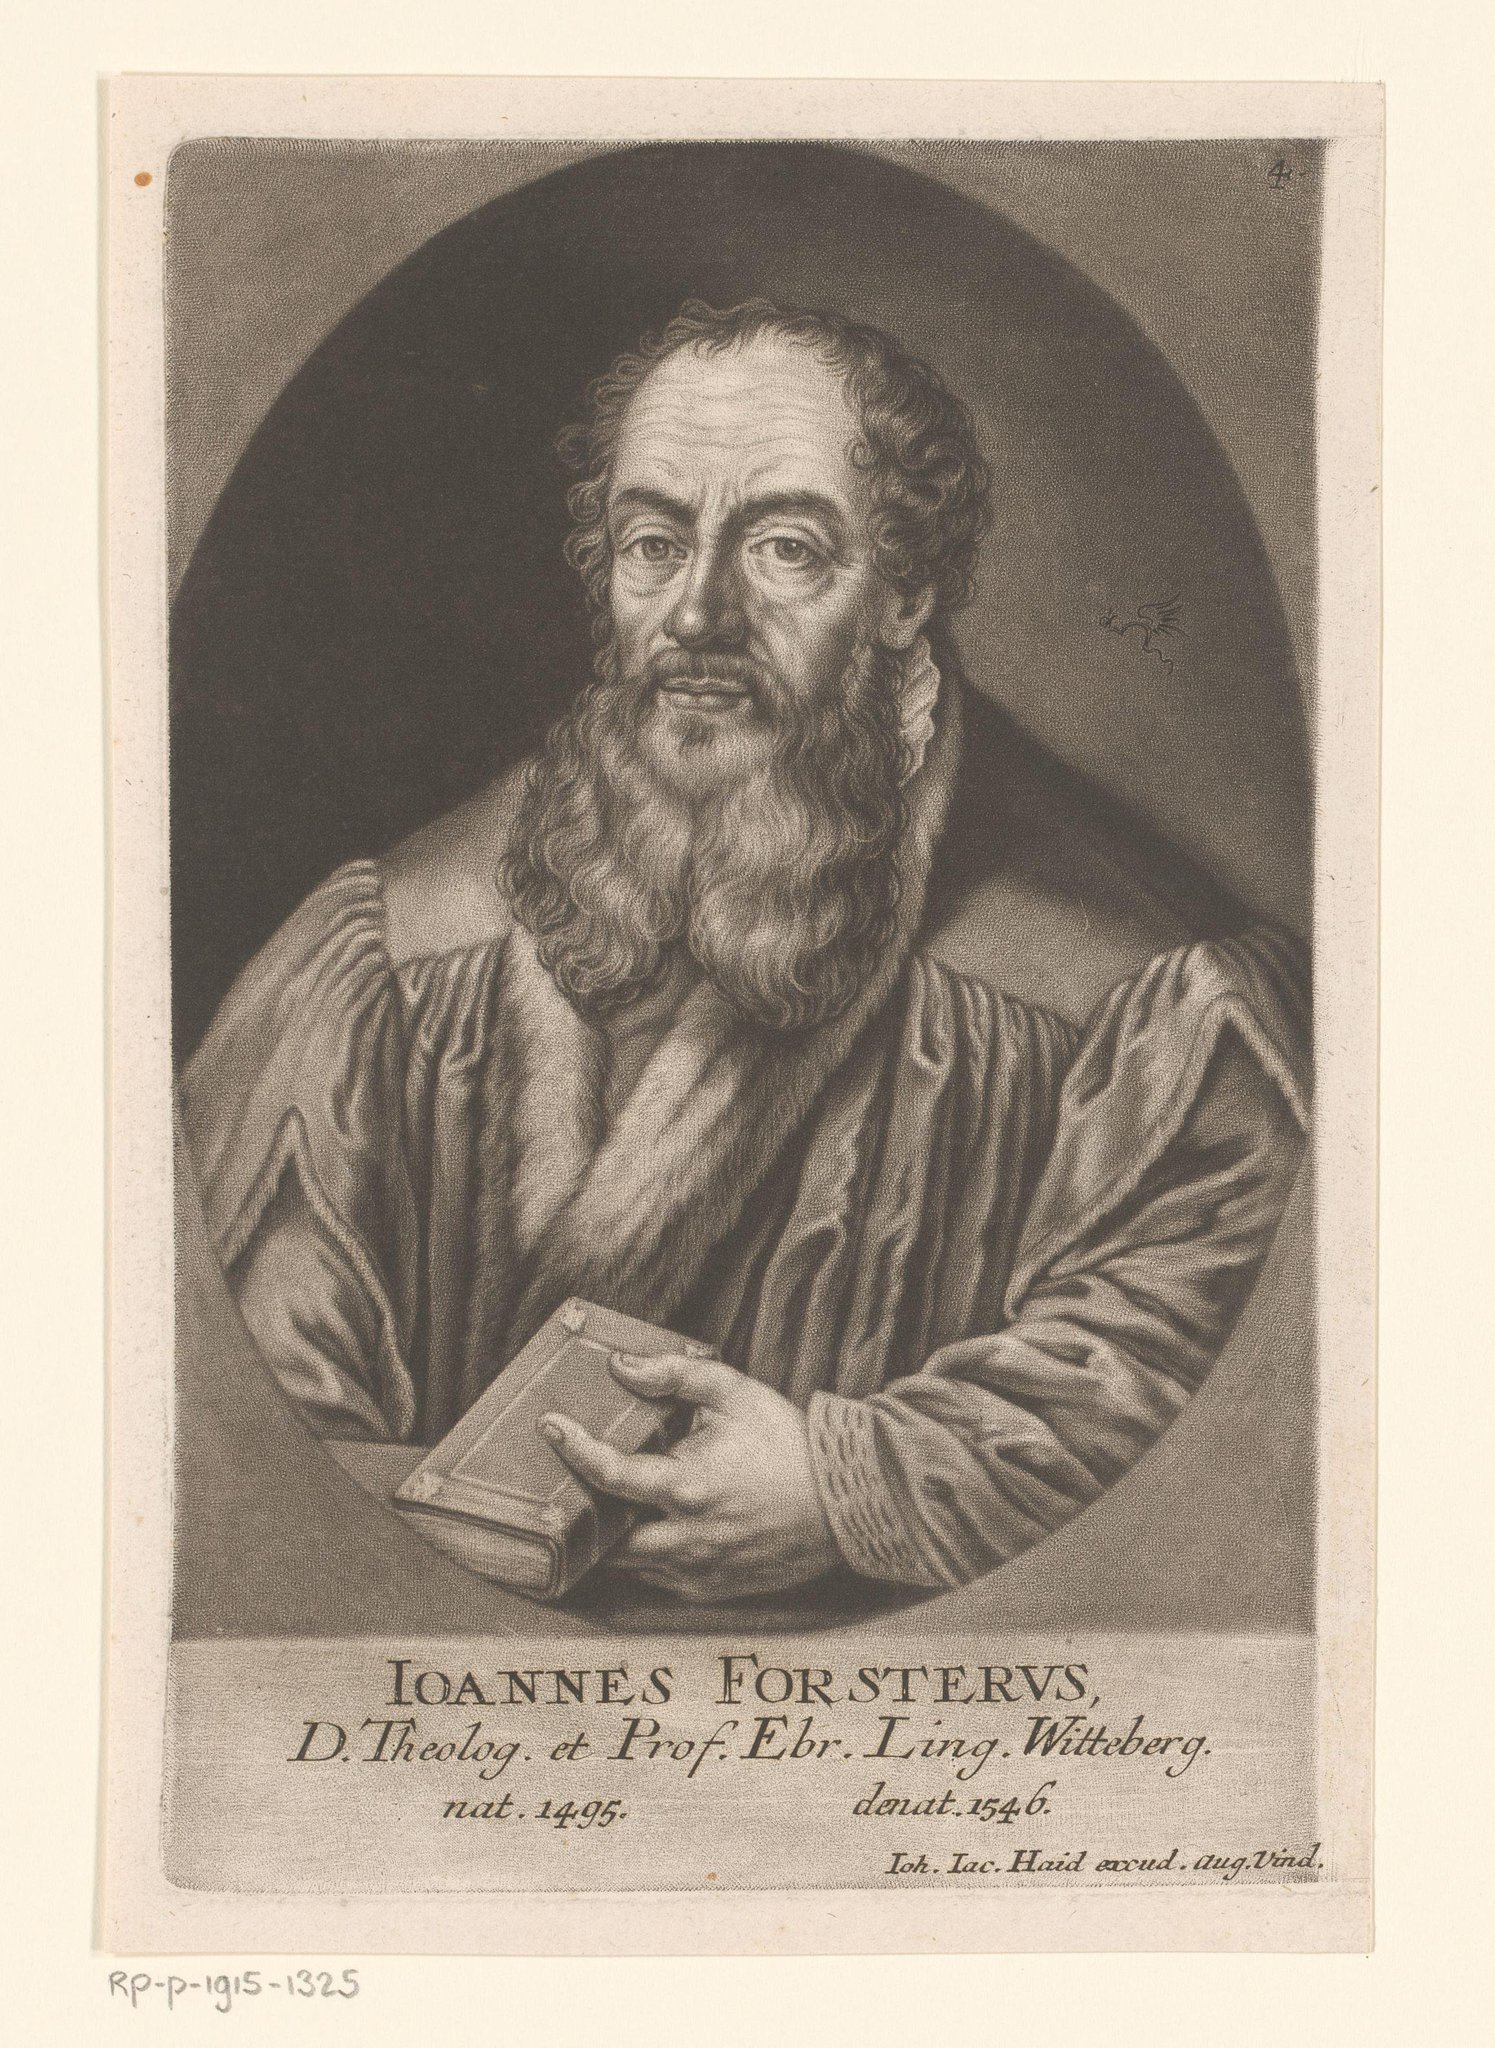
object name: print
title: Portret van Johann Forster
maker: johann jacob haid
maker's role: print maker, publisher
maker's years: 1704-1767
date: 1747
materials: paper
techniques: mezzotint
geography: augsburg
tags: augsburg, theologian, historical persons, book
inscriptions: collector's mark: Lugt 2228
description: Prent gebruikt voor: Brucker, Jacob. Ehrentempel der Deutschen Gelehrsamkeit. Augsburg: Johann Jacob Haid, 1747.